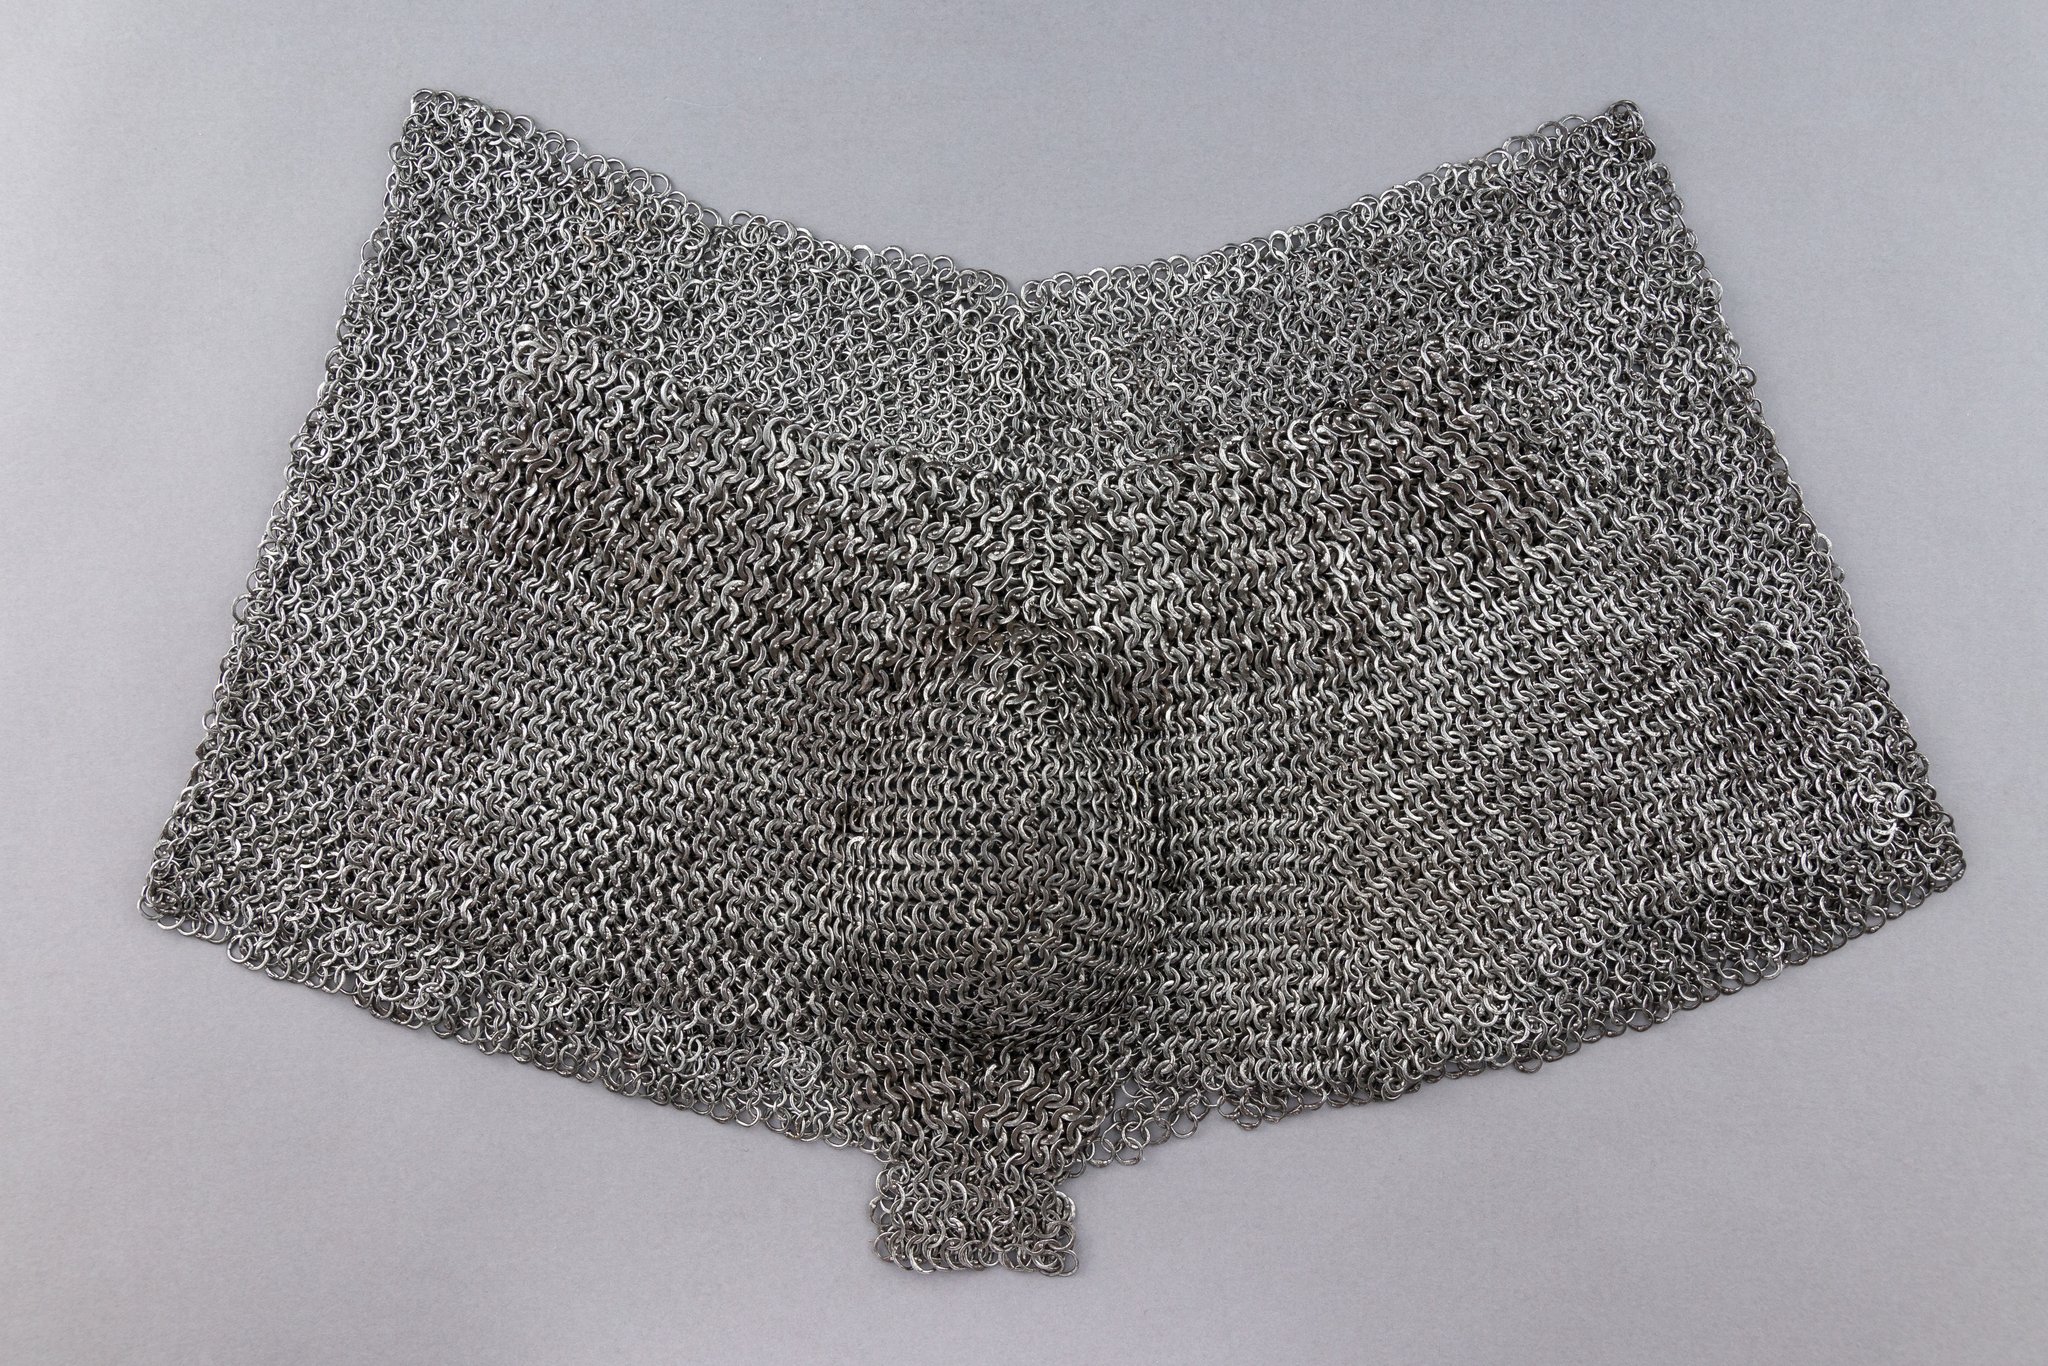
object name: brayette and buttock defense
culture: german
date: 1501-1600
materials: copper alloy, steel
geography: germany